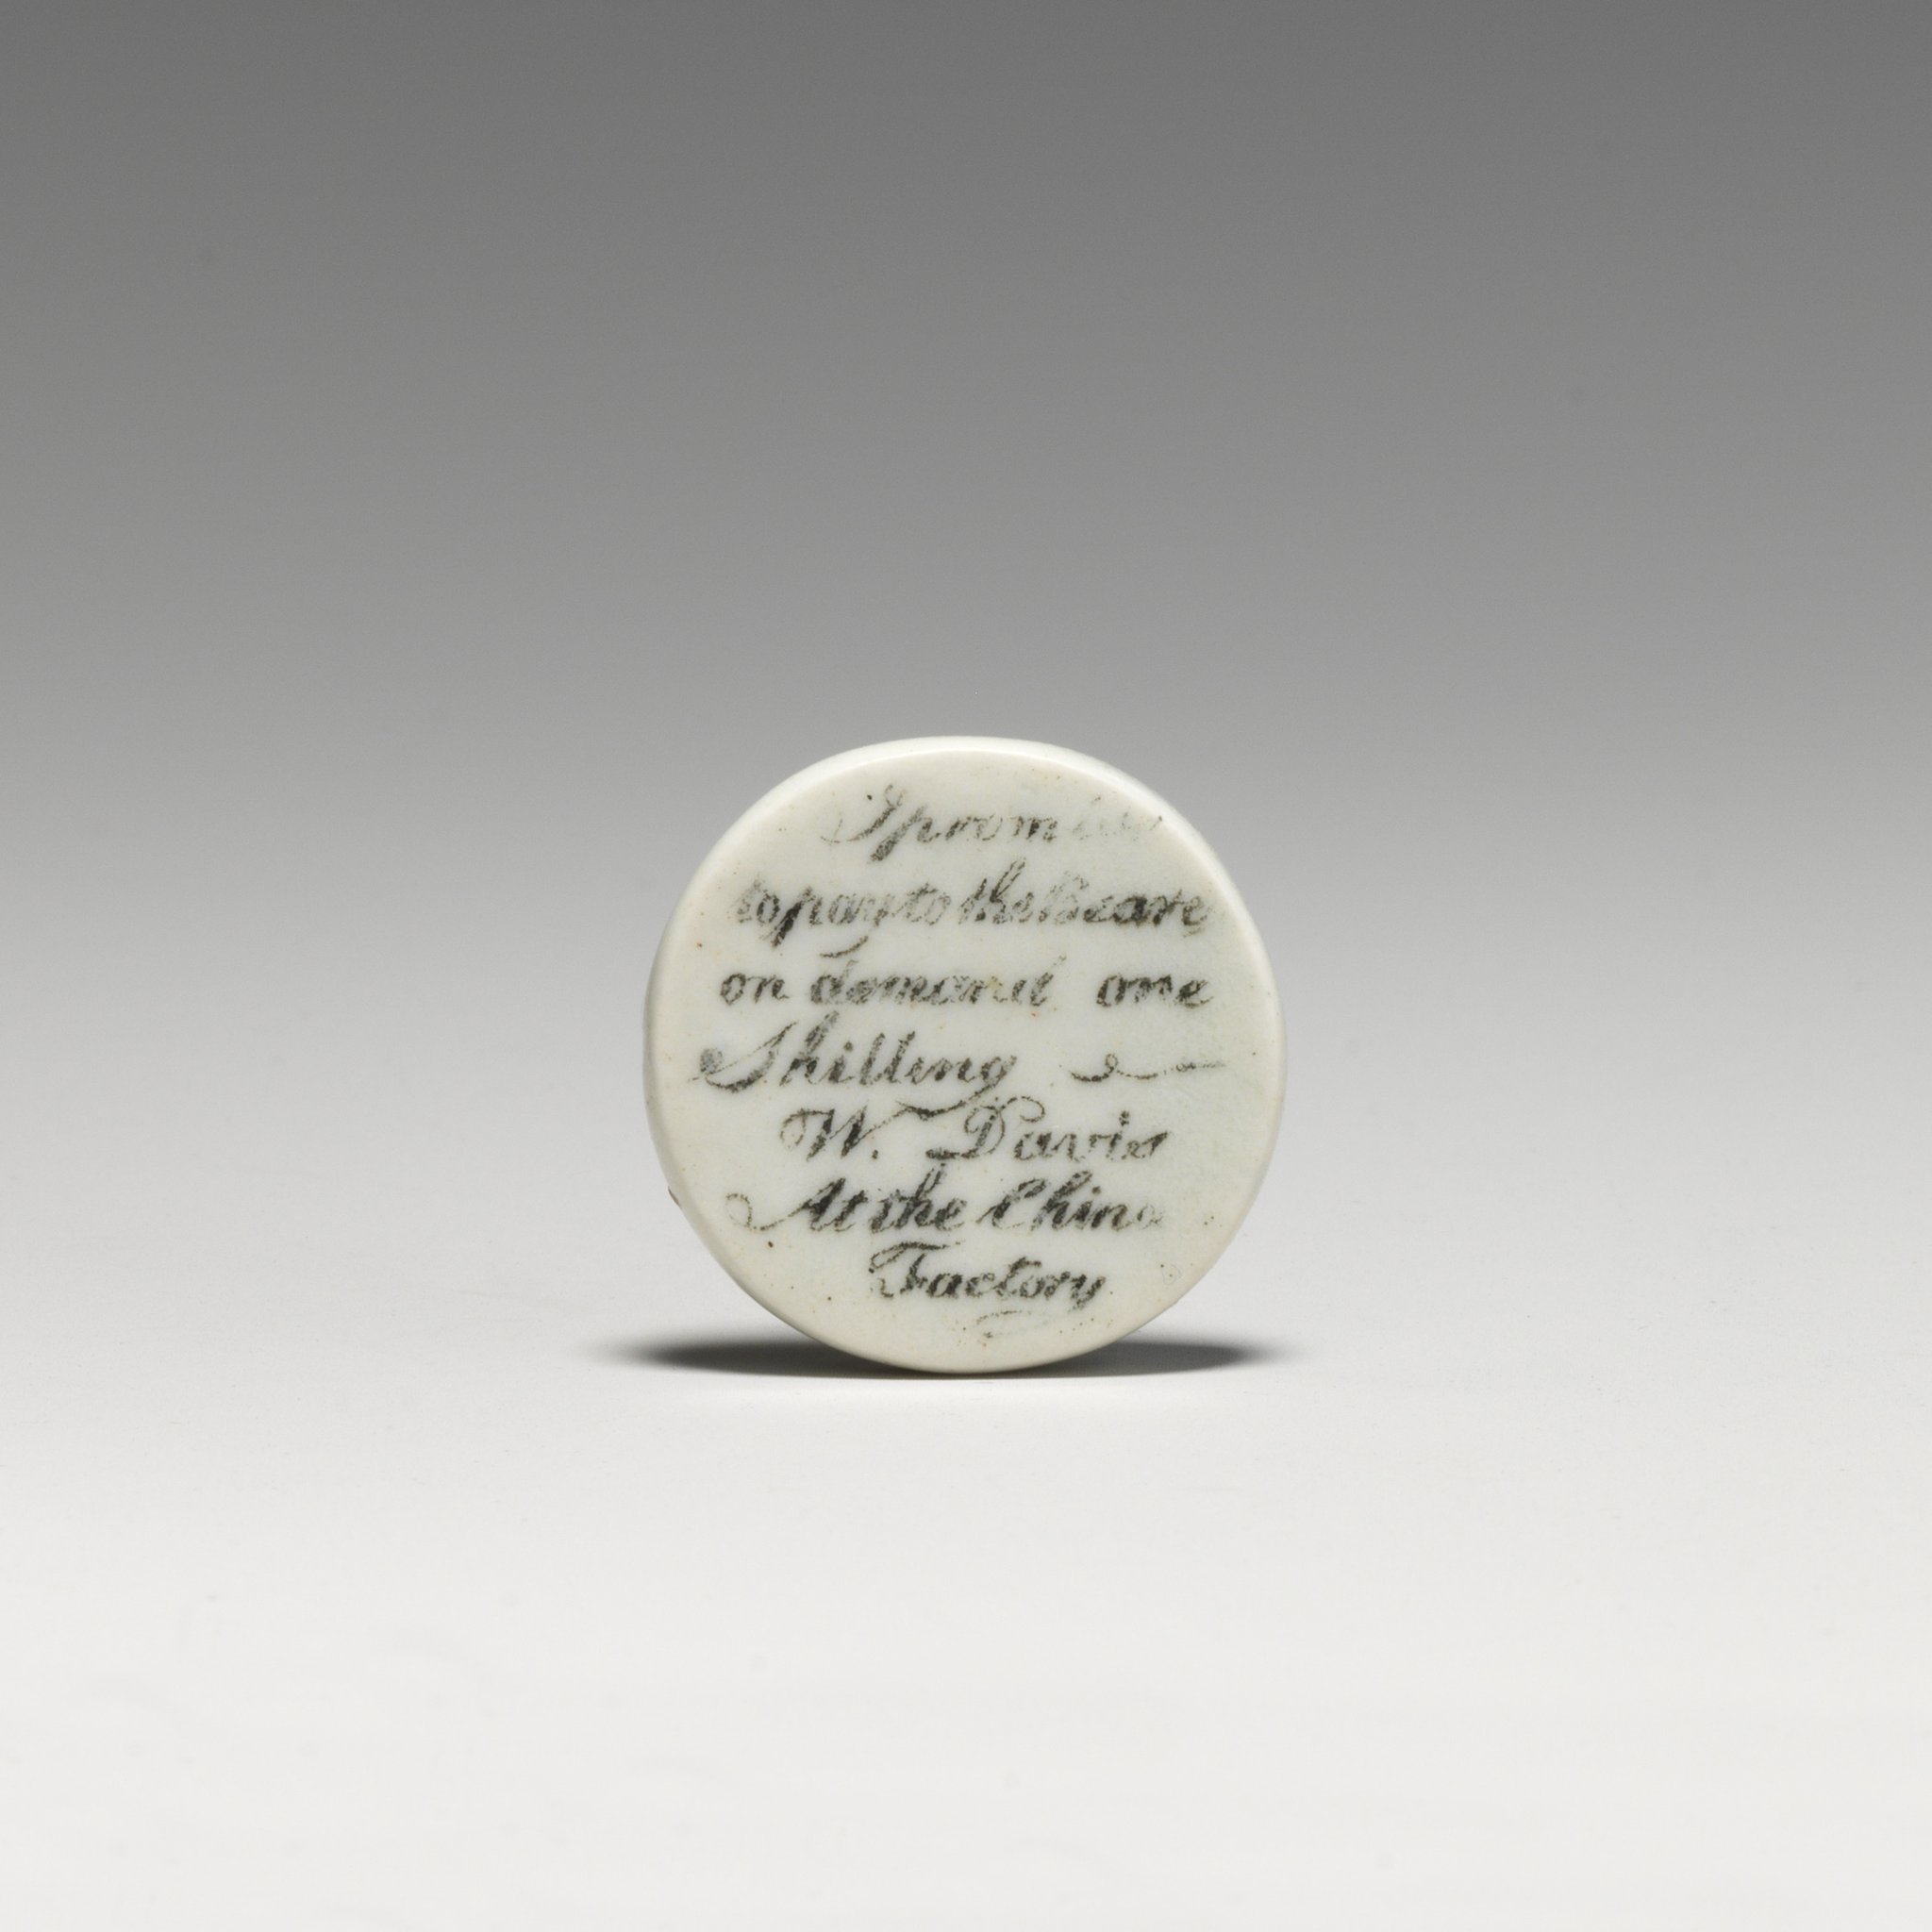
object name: token money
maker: worcester factory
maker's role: factory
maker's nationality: british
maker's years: 1751-2008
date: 1780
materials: soft paste porcelain